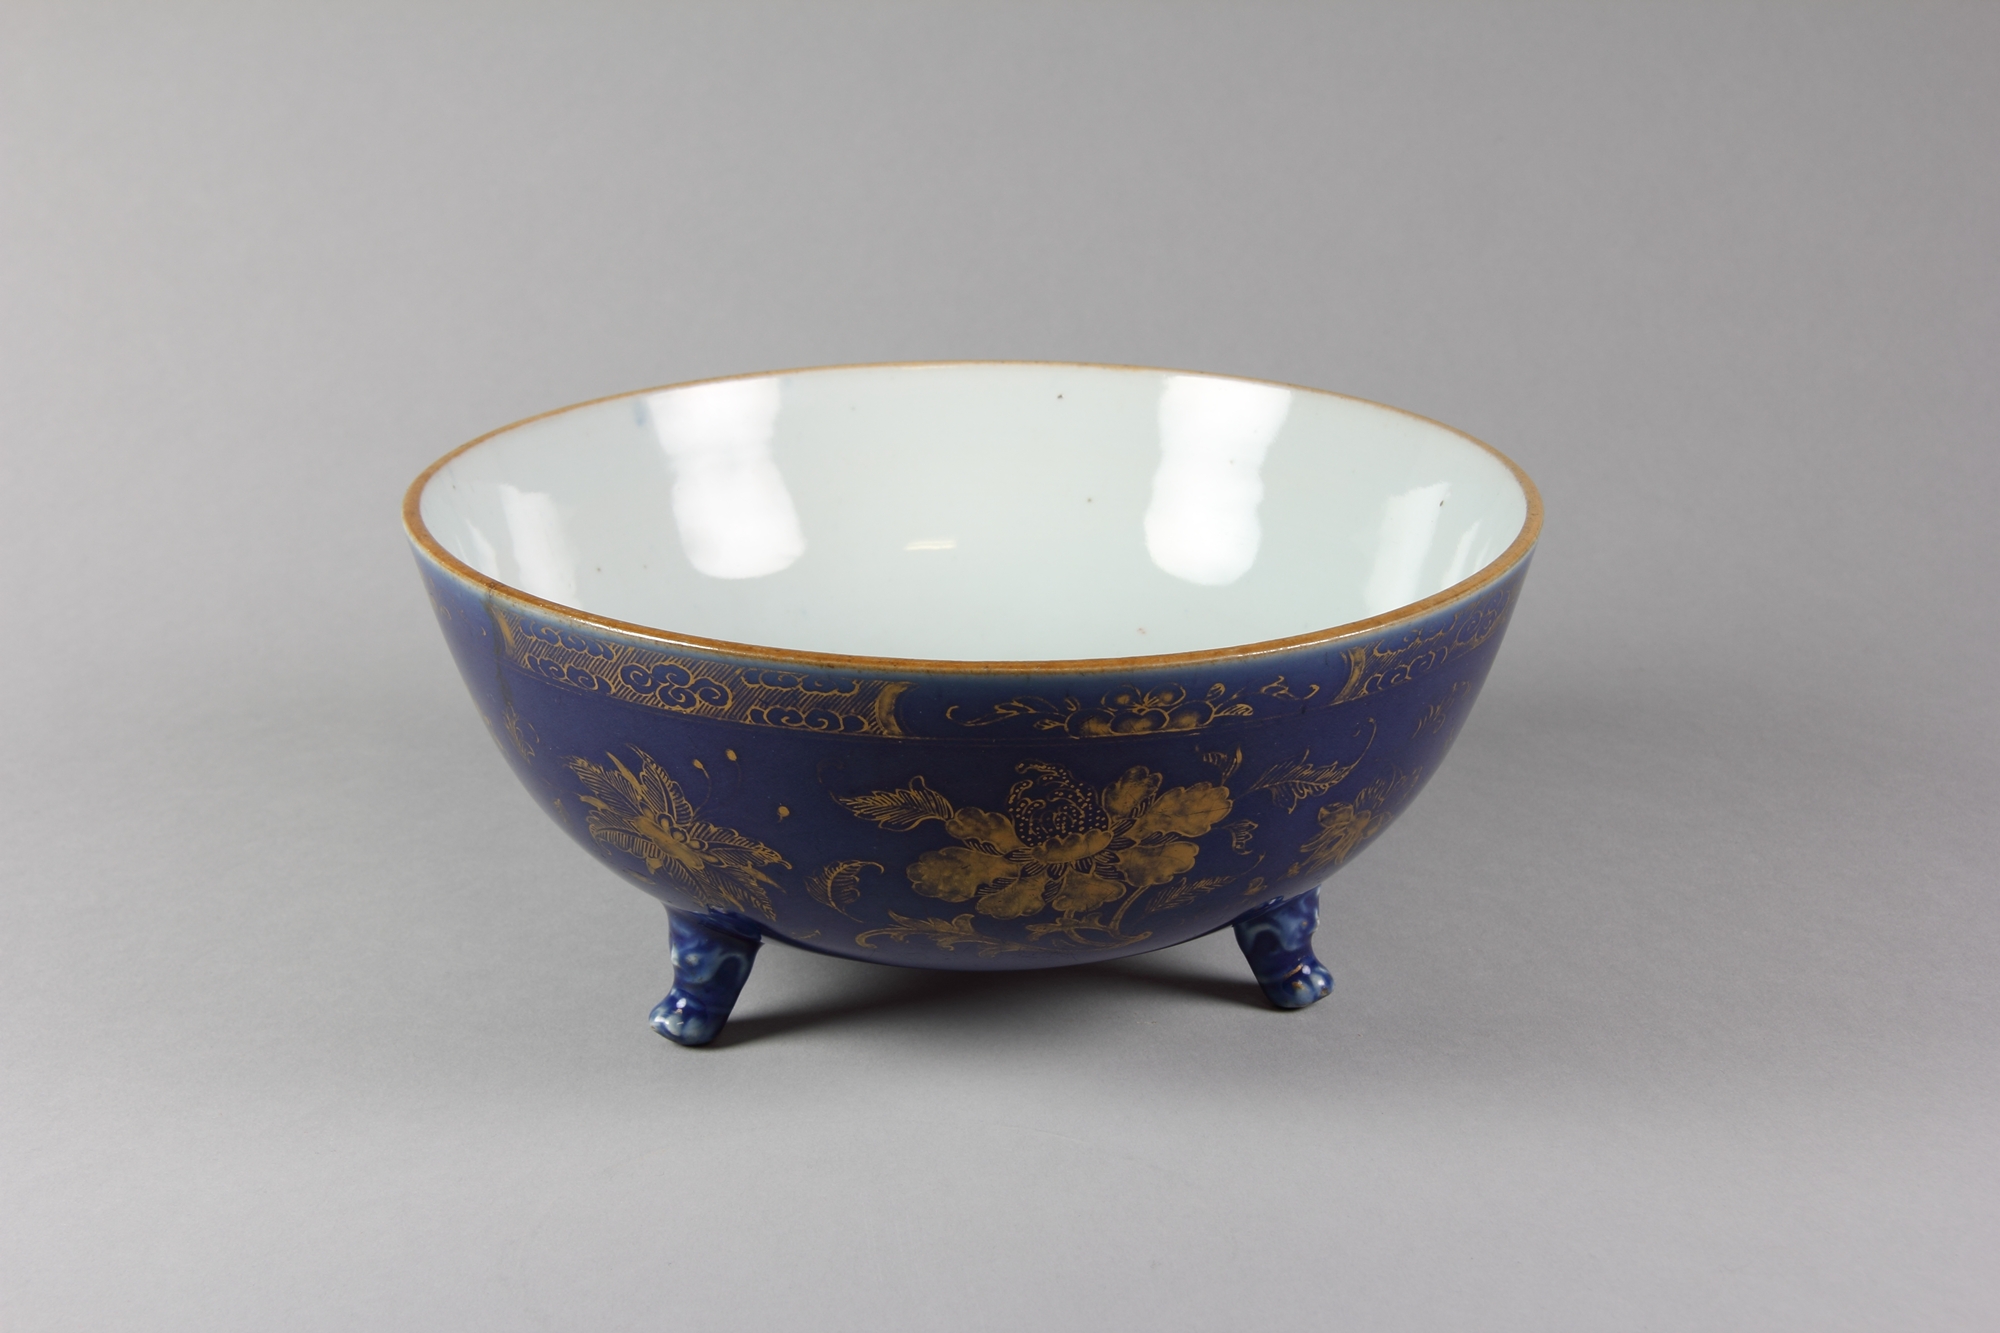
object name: bowl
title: Three-footed bowl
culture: chinese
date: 1767-1800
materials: gilt, glaze, porcelain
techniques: painting